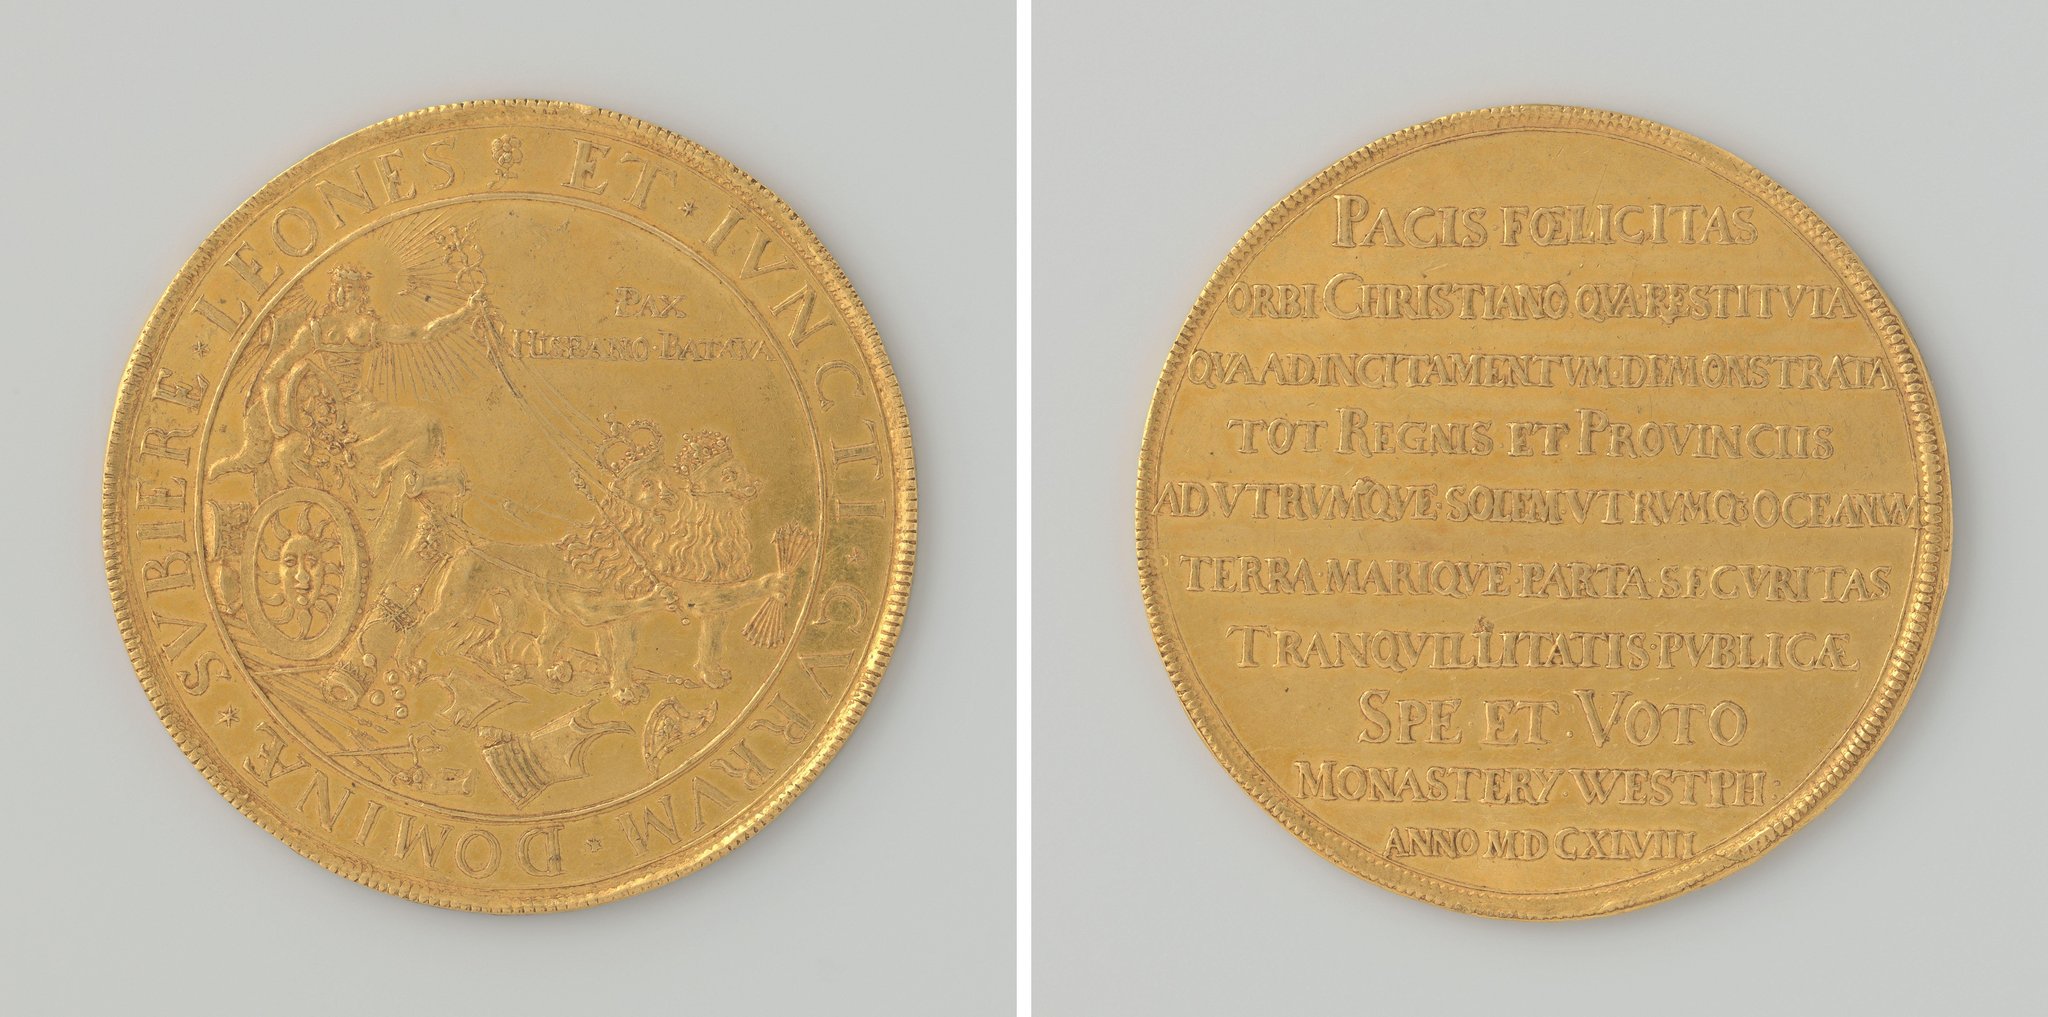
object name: medal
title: The Peace of Münster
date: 1648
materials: gold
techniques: striking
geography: munster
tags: vrede van münster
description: Together two crowned lions pull a chariot of victory. The lion with a sceptre represents Spain; the other one, with a sheaf of arrows, the Dutch Republic. Destroyed weapons lie scattered on the ground under the chariot and the animals. This is an interpretation of the peace concluded between the two countries in Münster in 1648. The Spanish negotiator, Peñaranda, had this medal struck to celebrate this successful outcome.